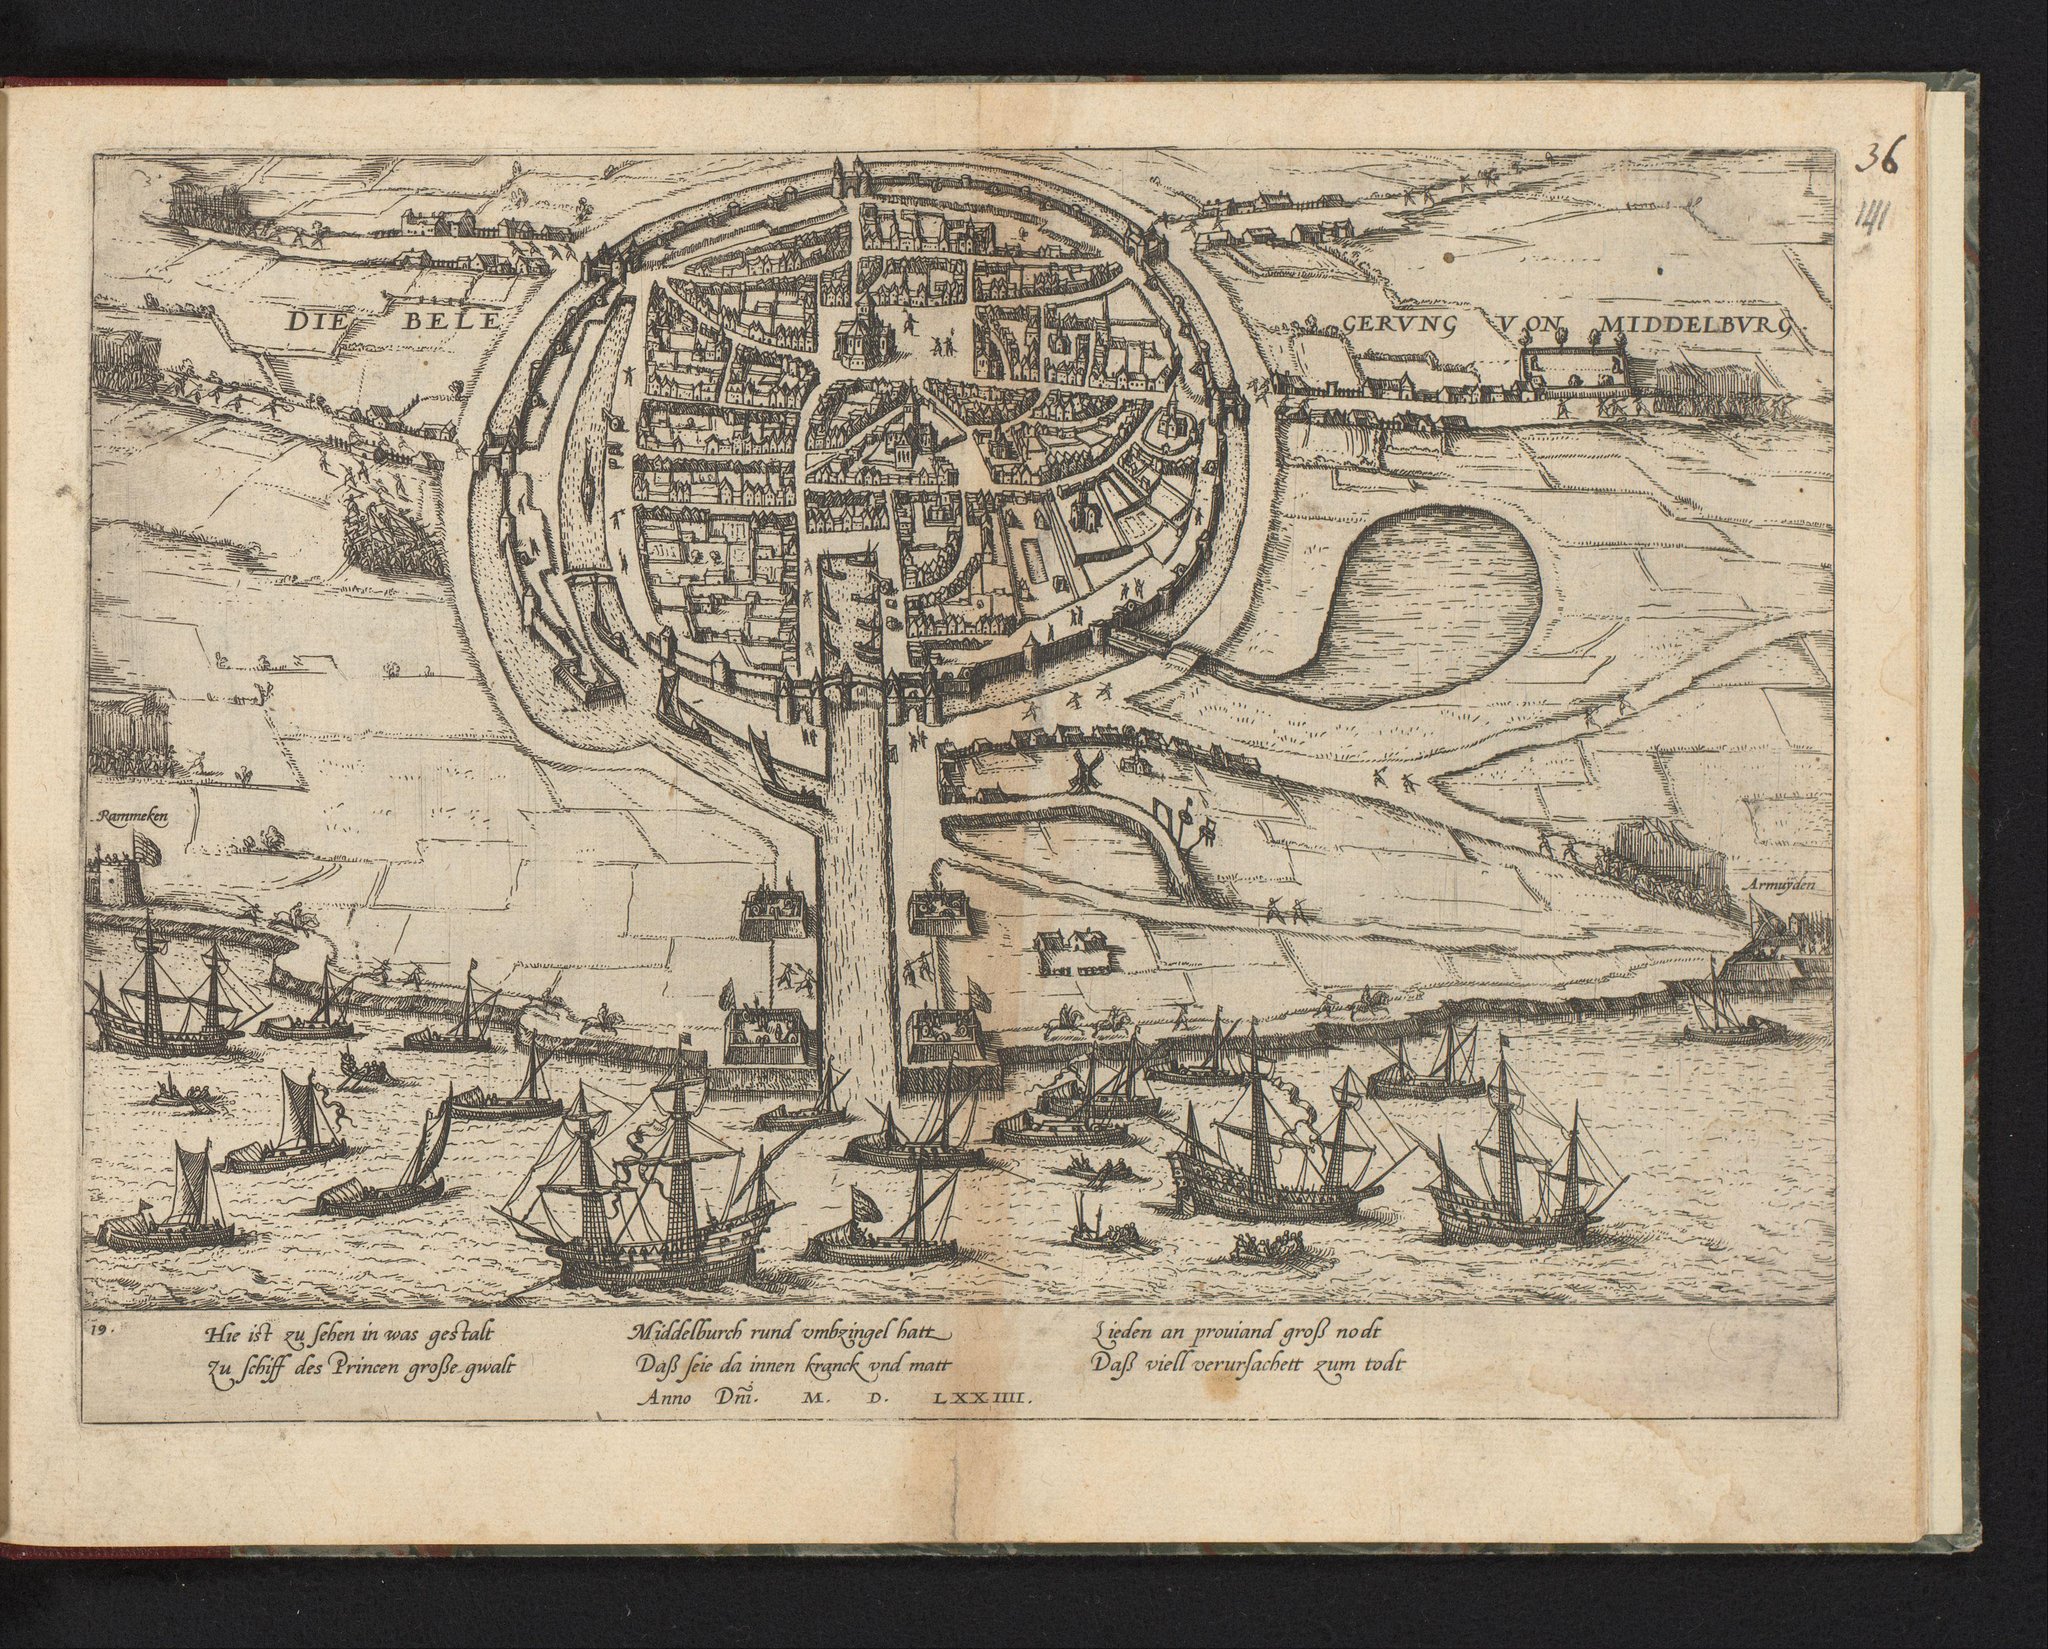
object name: album leaf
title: Serie 6: Nederlandse Gebeurtenissen, 1571-1576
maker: frans hogenberg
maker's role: print maker, publisher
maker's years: 1538-1590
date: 1574-1576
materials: paper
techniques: etching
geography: cologne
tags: siege, position war, middelburg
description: Beleg van Middelburg door de opstandelingen, januari 1574. Gezicht op de belegerde stad en de omgeving. Op de voorgrond de schepen van de geuzen, Fort Rammekens en Arnemuiden. Met onderschrift van 6 regels in het Duits. Genummerd: 19. De prent maakt deel uit van een album.